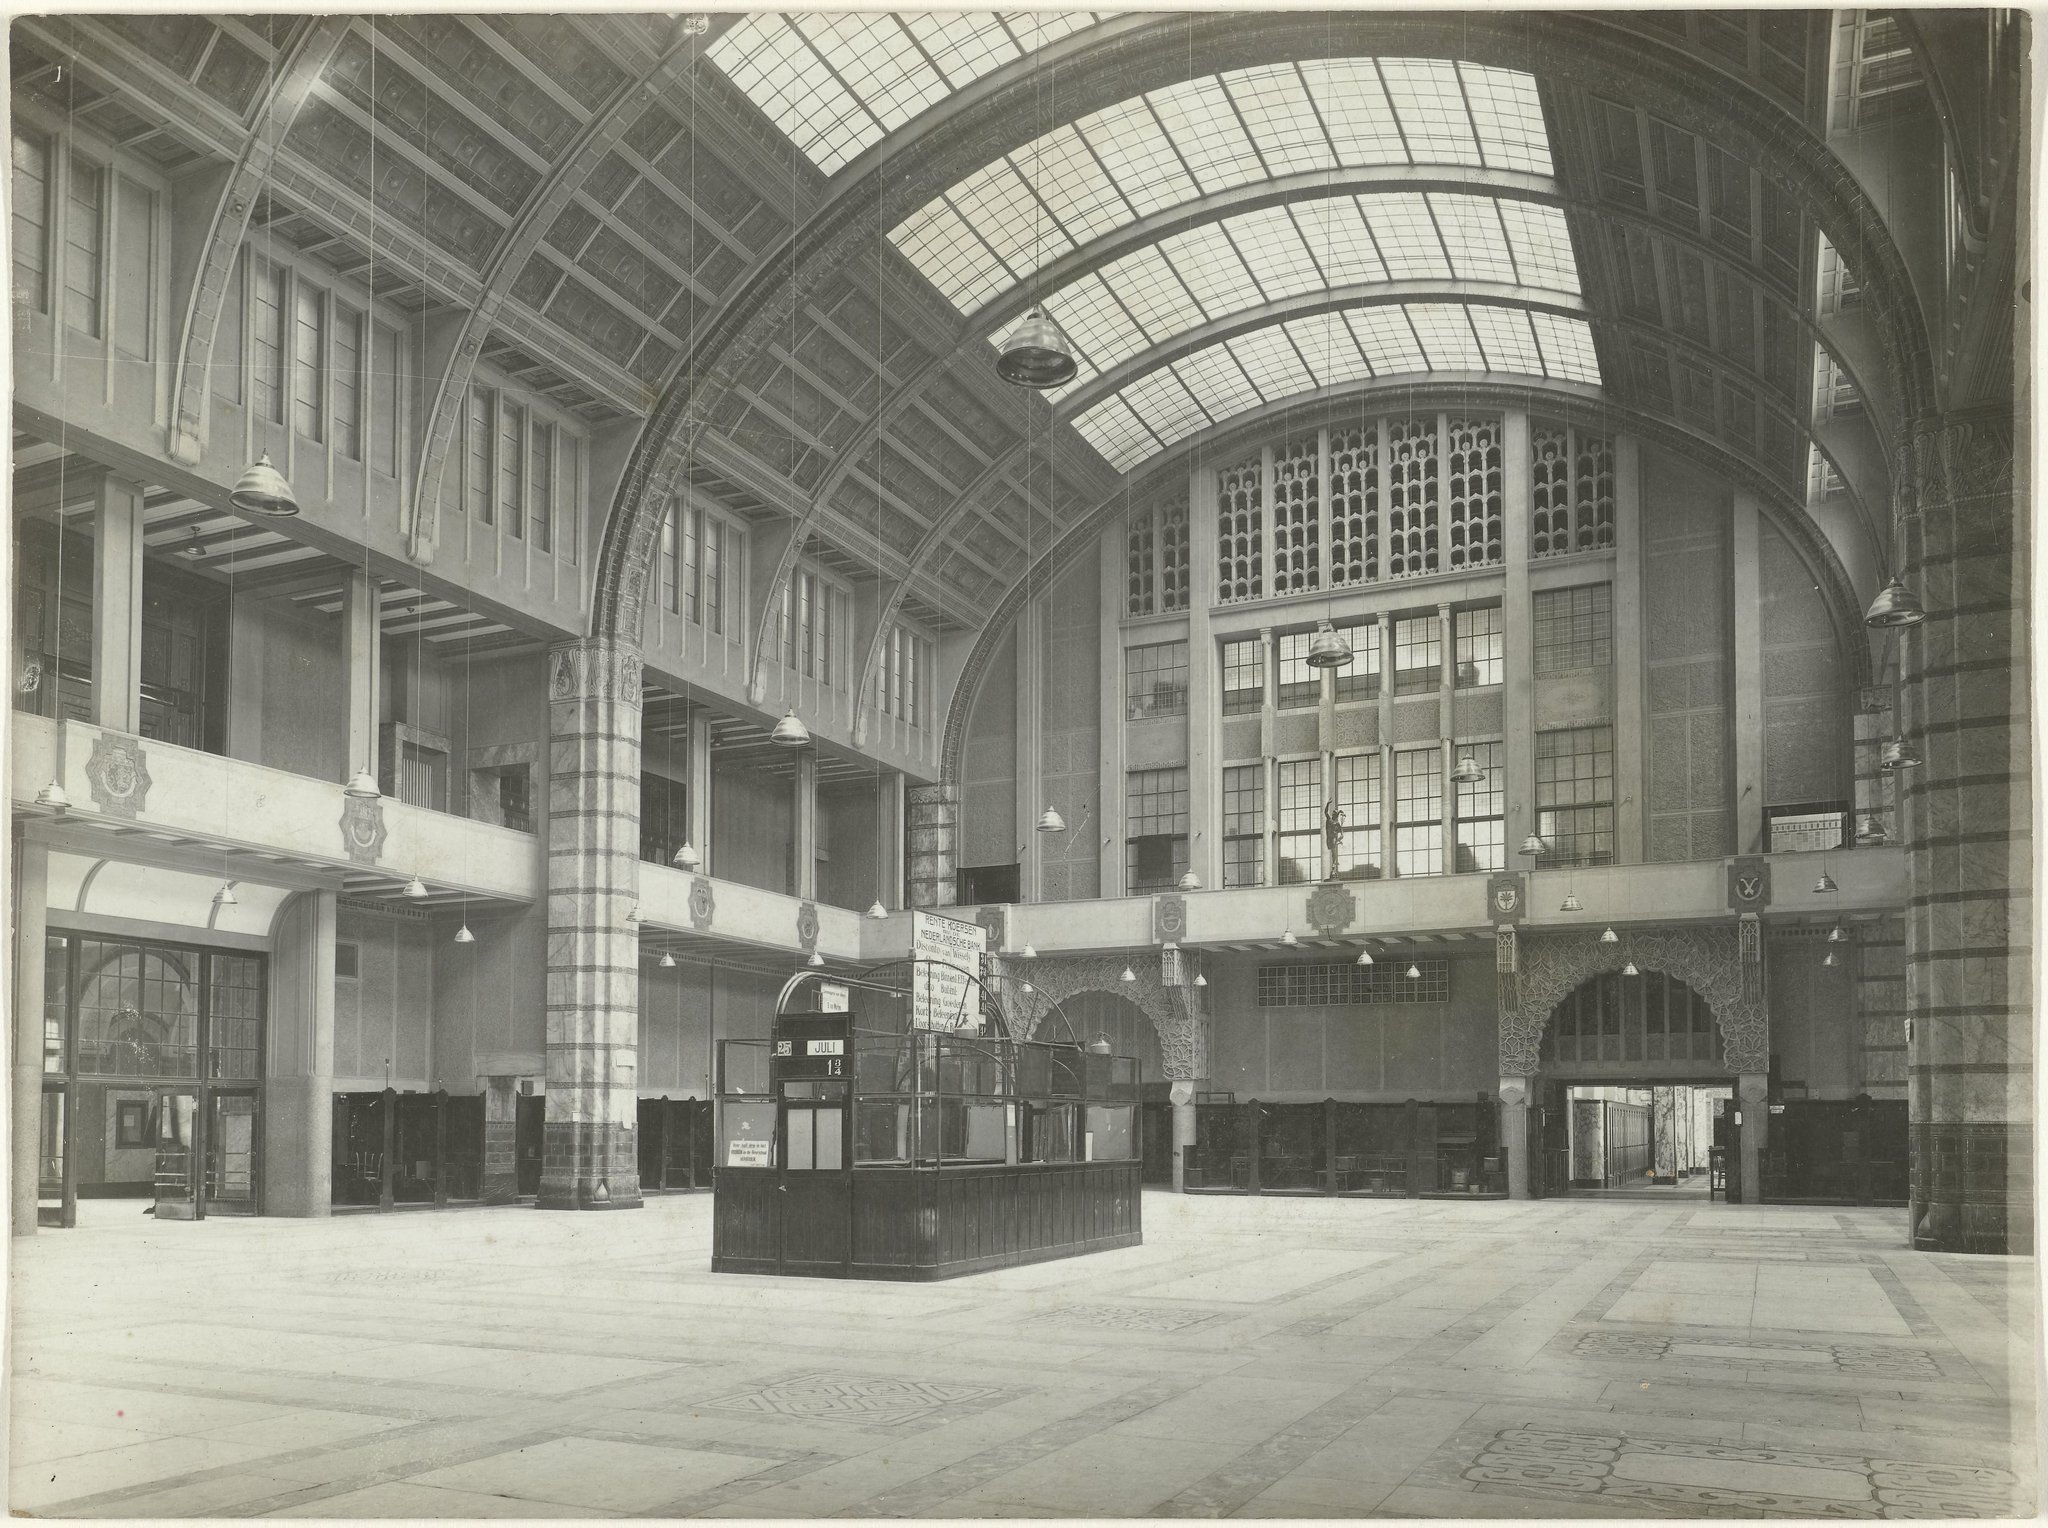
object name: photograph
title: Interieur van de effectenbeurs te Amsterdam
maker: Anonymous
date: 1913-1940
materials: photographic support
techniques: gelatin silver print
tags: beursplein